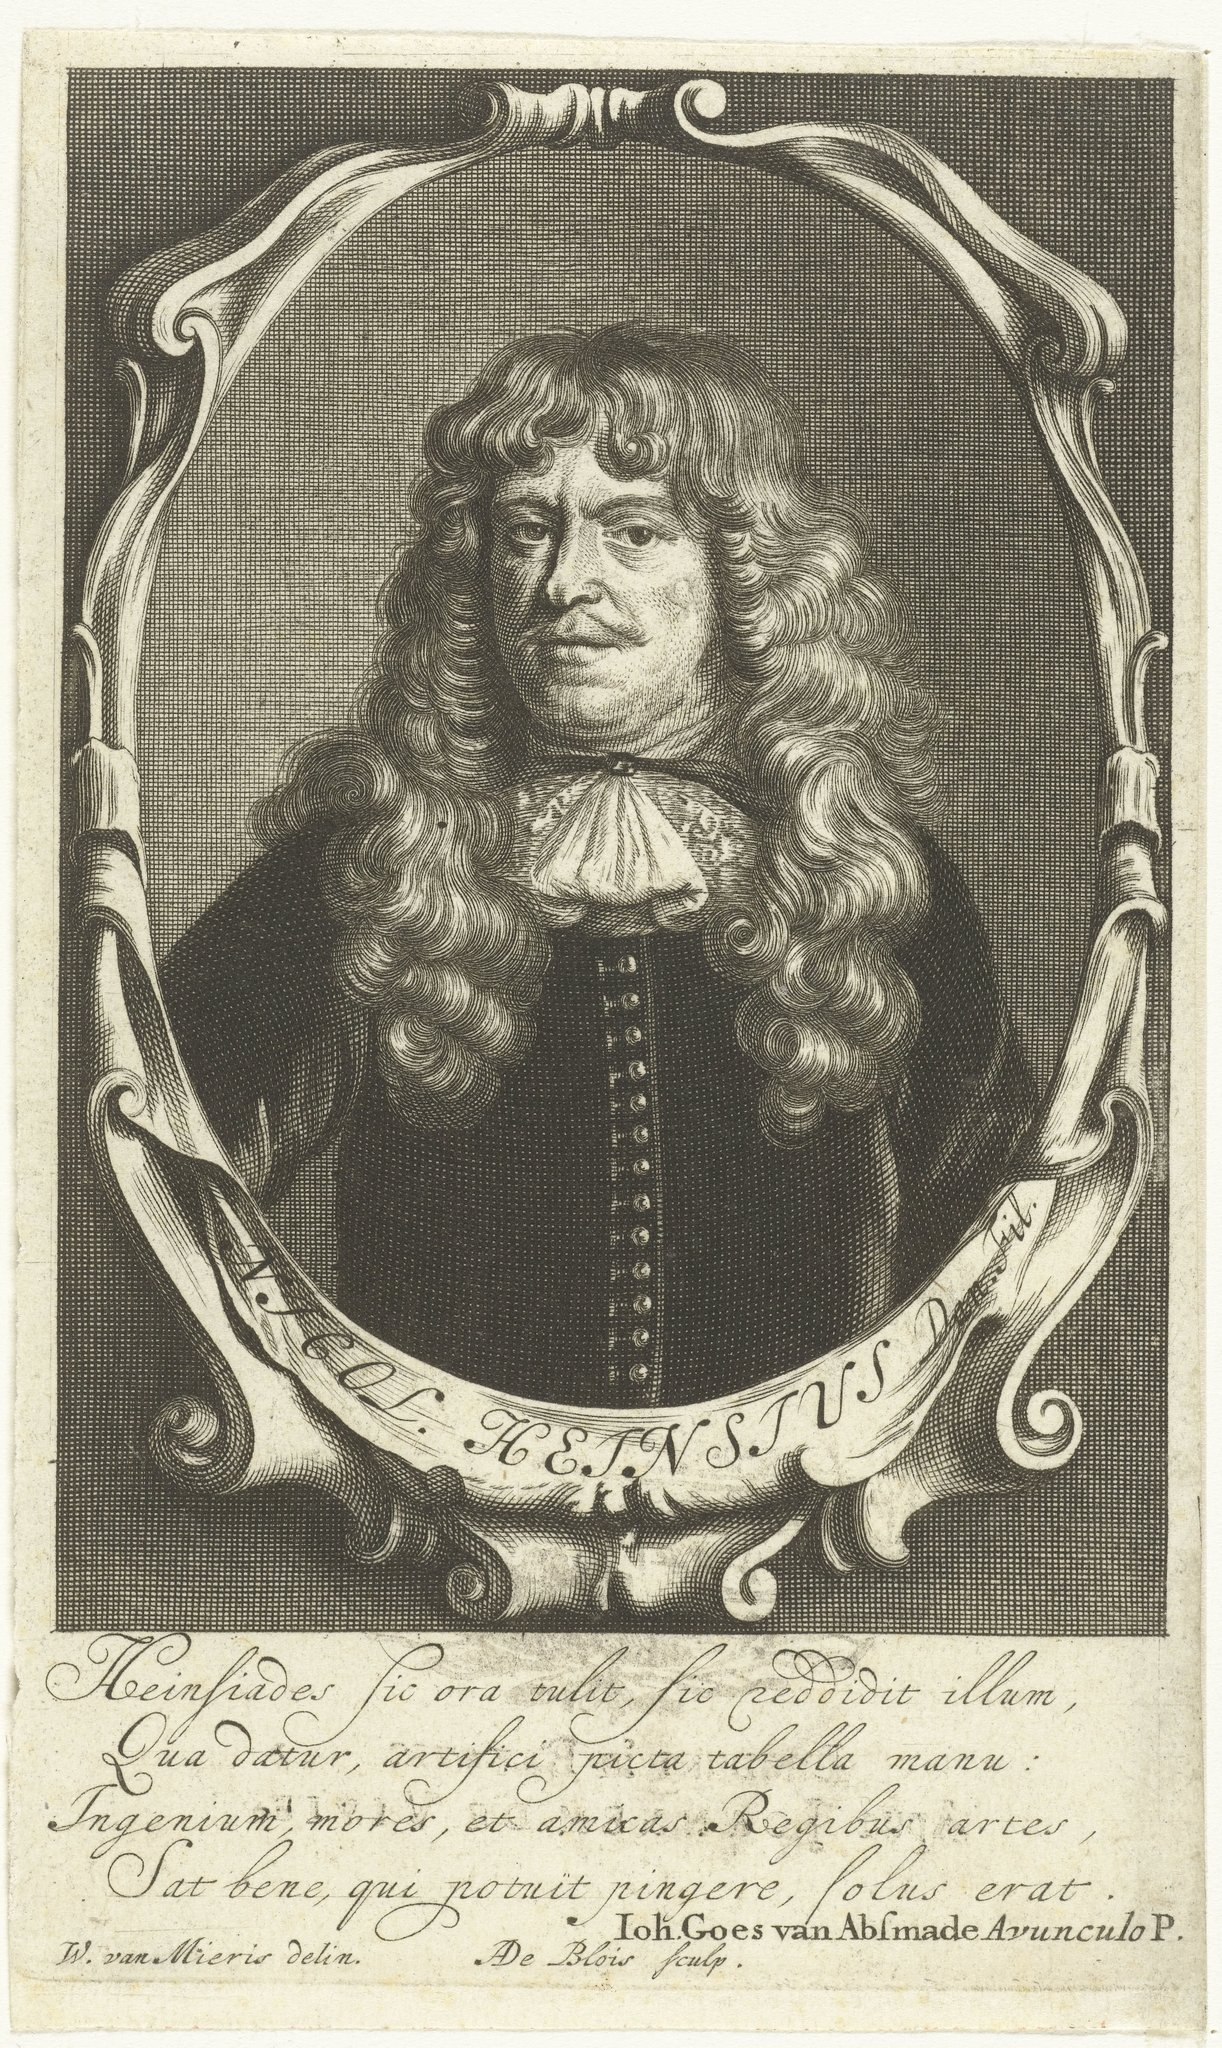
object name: print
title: Portret van Nicolaas Heinsius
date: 1679-1717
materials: paper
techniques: engraving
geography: amsterdam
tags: leiden, the hague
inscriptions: collector's mark: Lugt 2228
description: Portret van classicus en dichter Nicolaas Heinsius, buste in ovale omlijsting met krulornamenten. Onder het portret staat een vers waarin hij geroemd wordt.